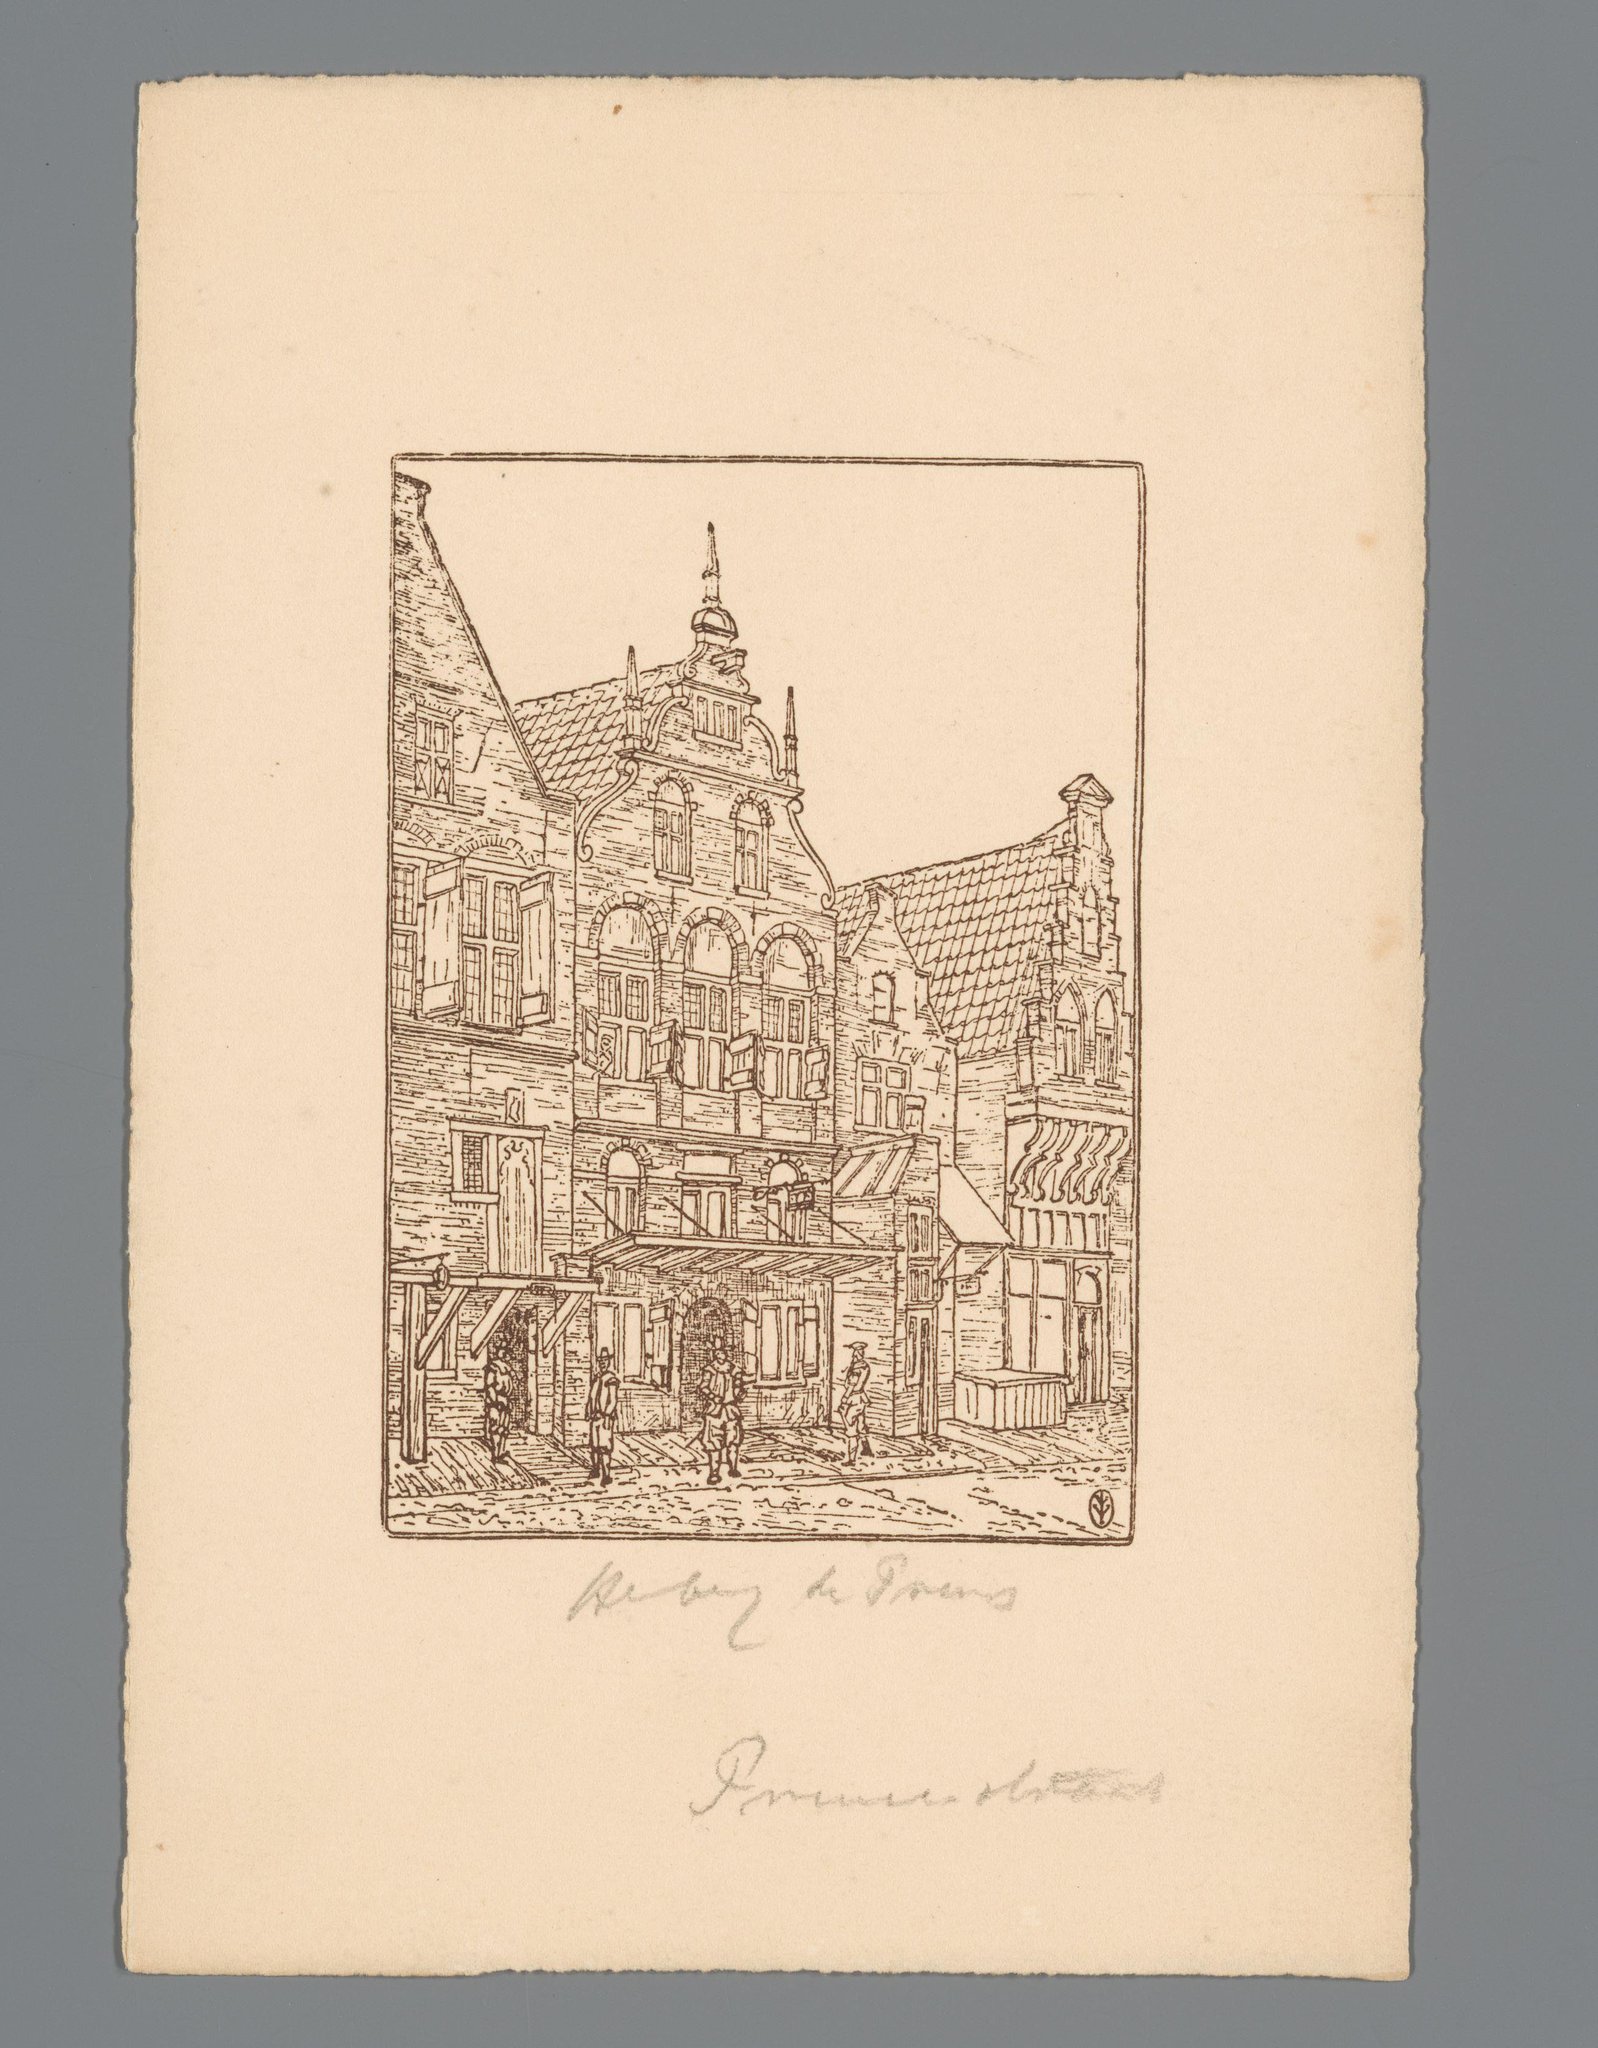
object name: print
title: Stadsgezicht in Amsterdam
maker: Anonymous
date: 1800-1900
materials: paper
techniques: lithograph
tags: façade (of house or building), street, amsterdam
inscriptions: monogram